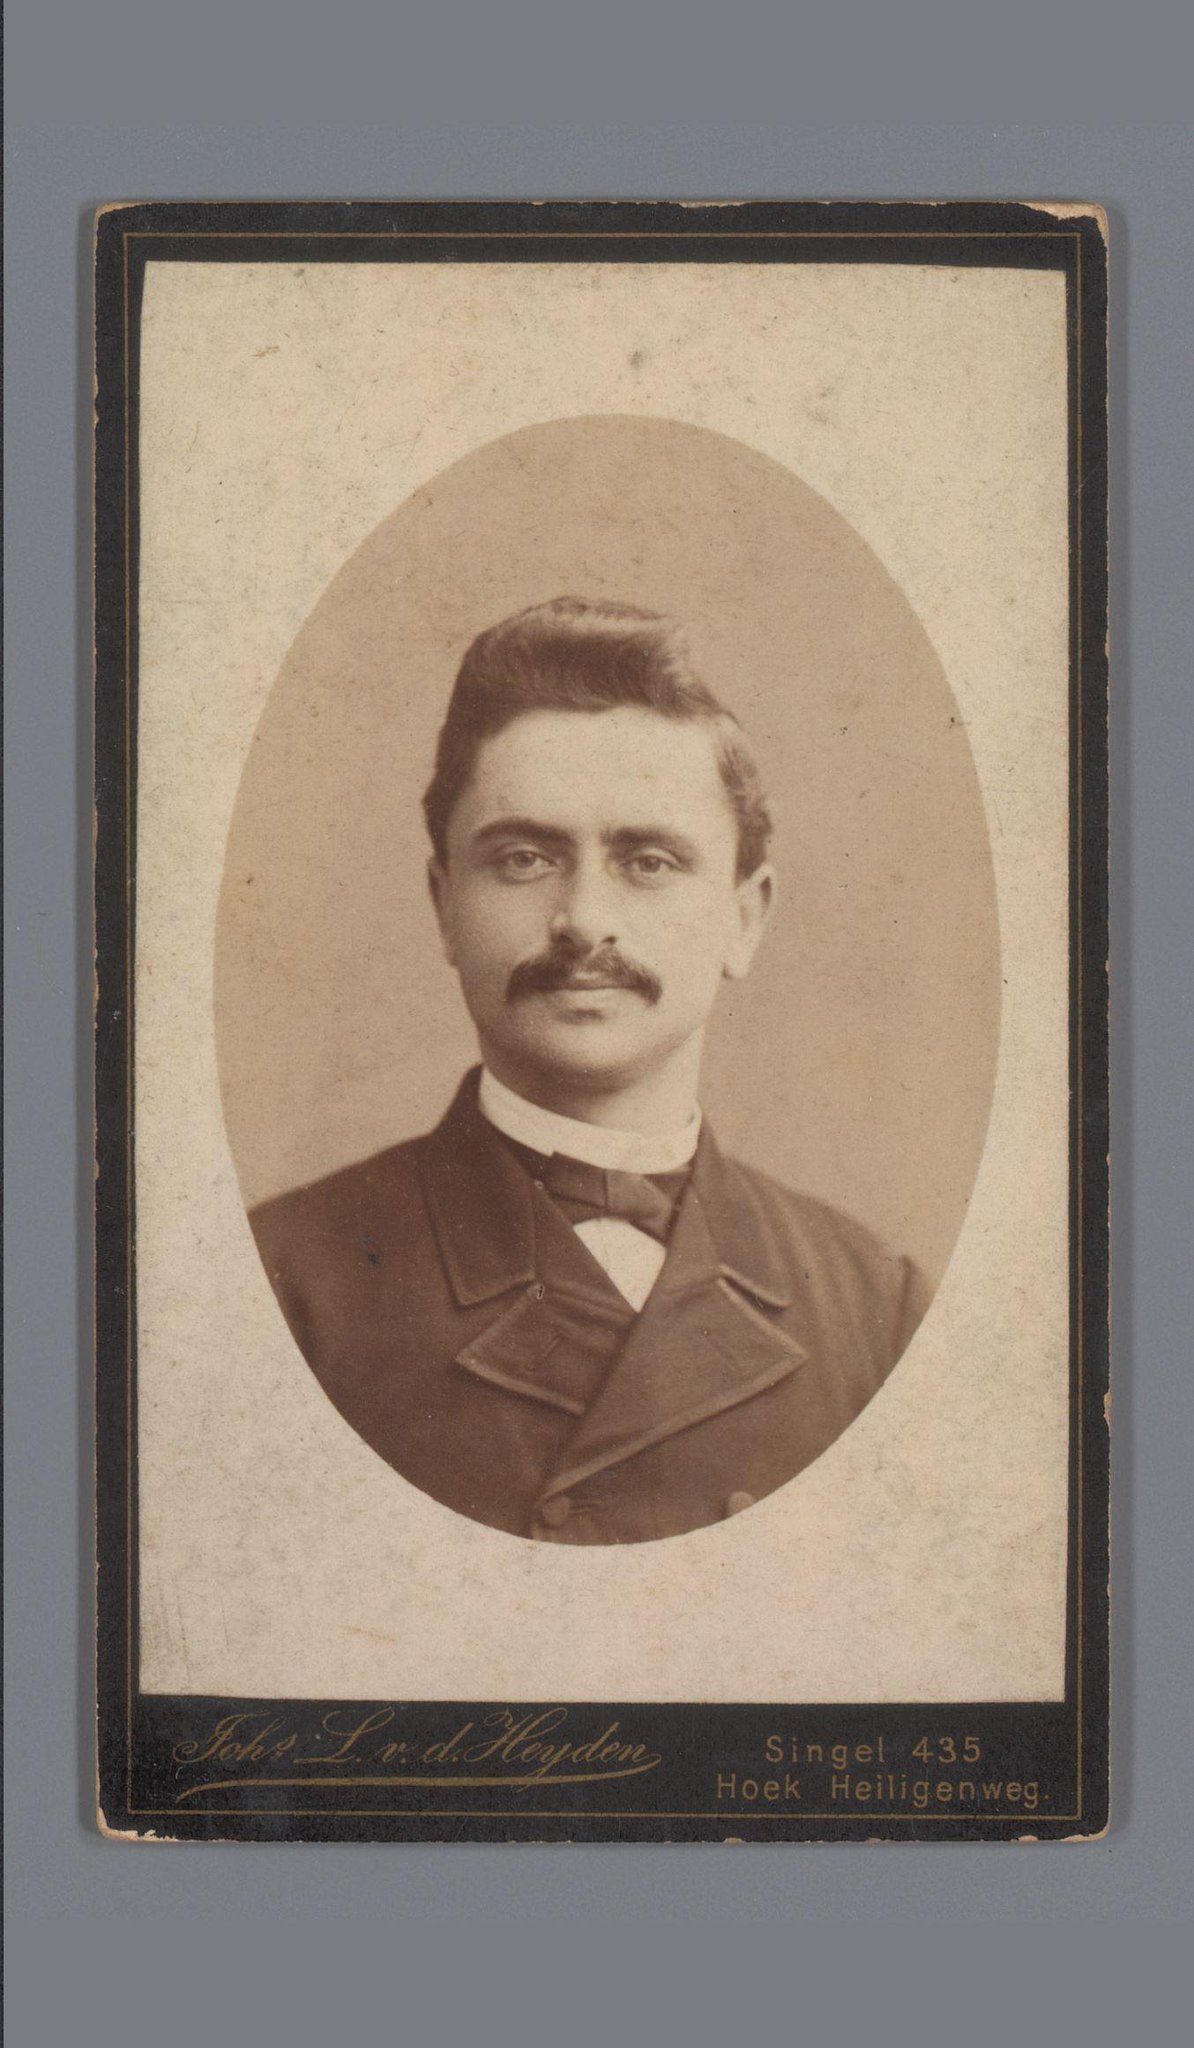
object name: photograph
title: Portret van een onbekende man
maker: johannes leonardus van der heijden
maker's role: fotograaf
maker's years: 1856-1937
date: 1875-1900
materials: cardboard, paper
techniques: albumen print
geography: amsterdam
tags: moustache, adult man, historical persons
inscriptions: inscription: ‘Johs L. v.d. Heijden/ AMSTERDAM Singel 435./ MUSTERSCHUTZ A.L.’